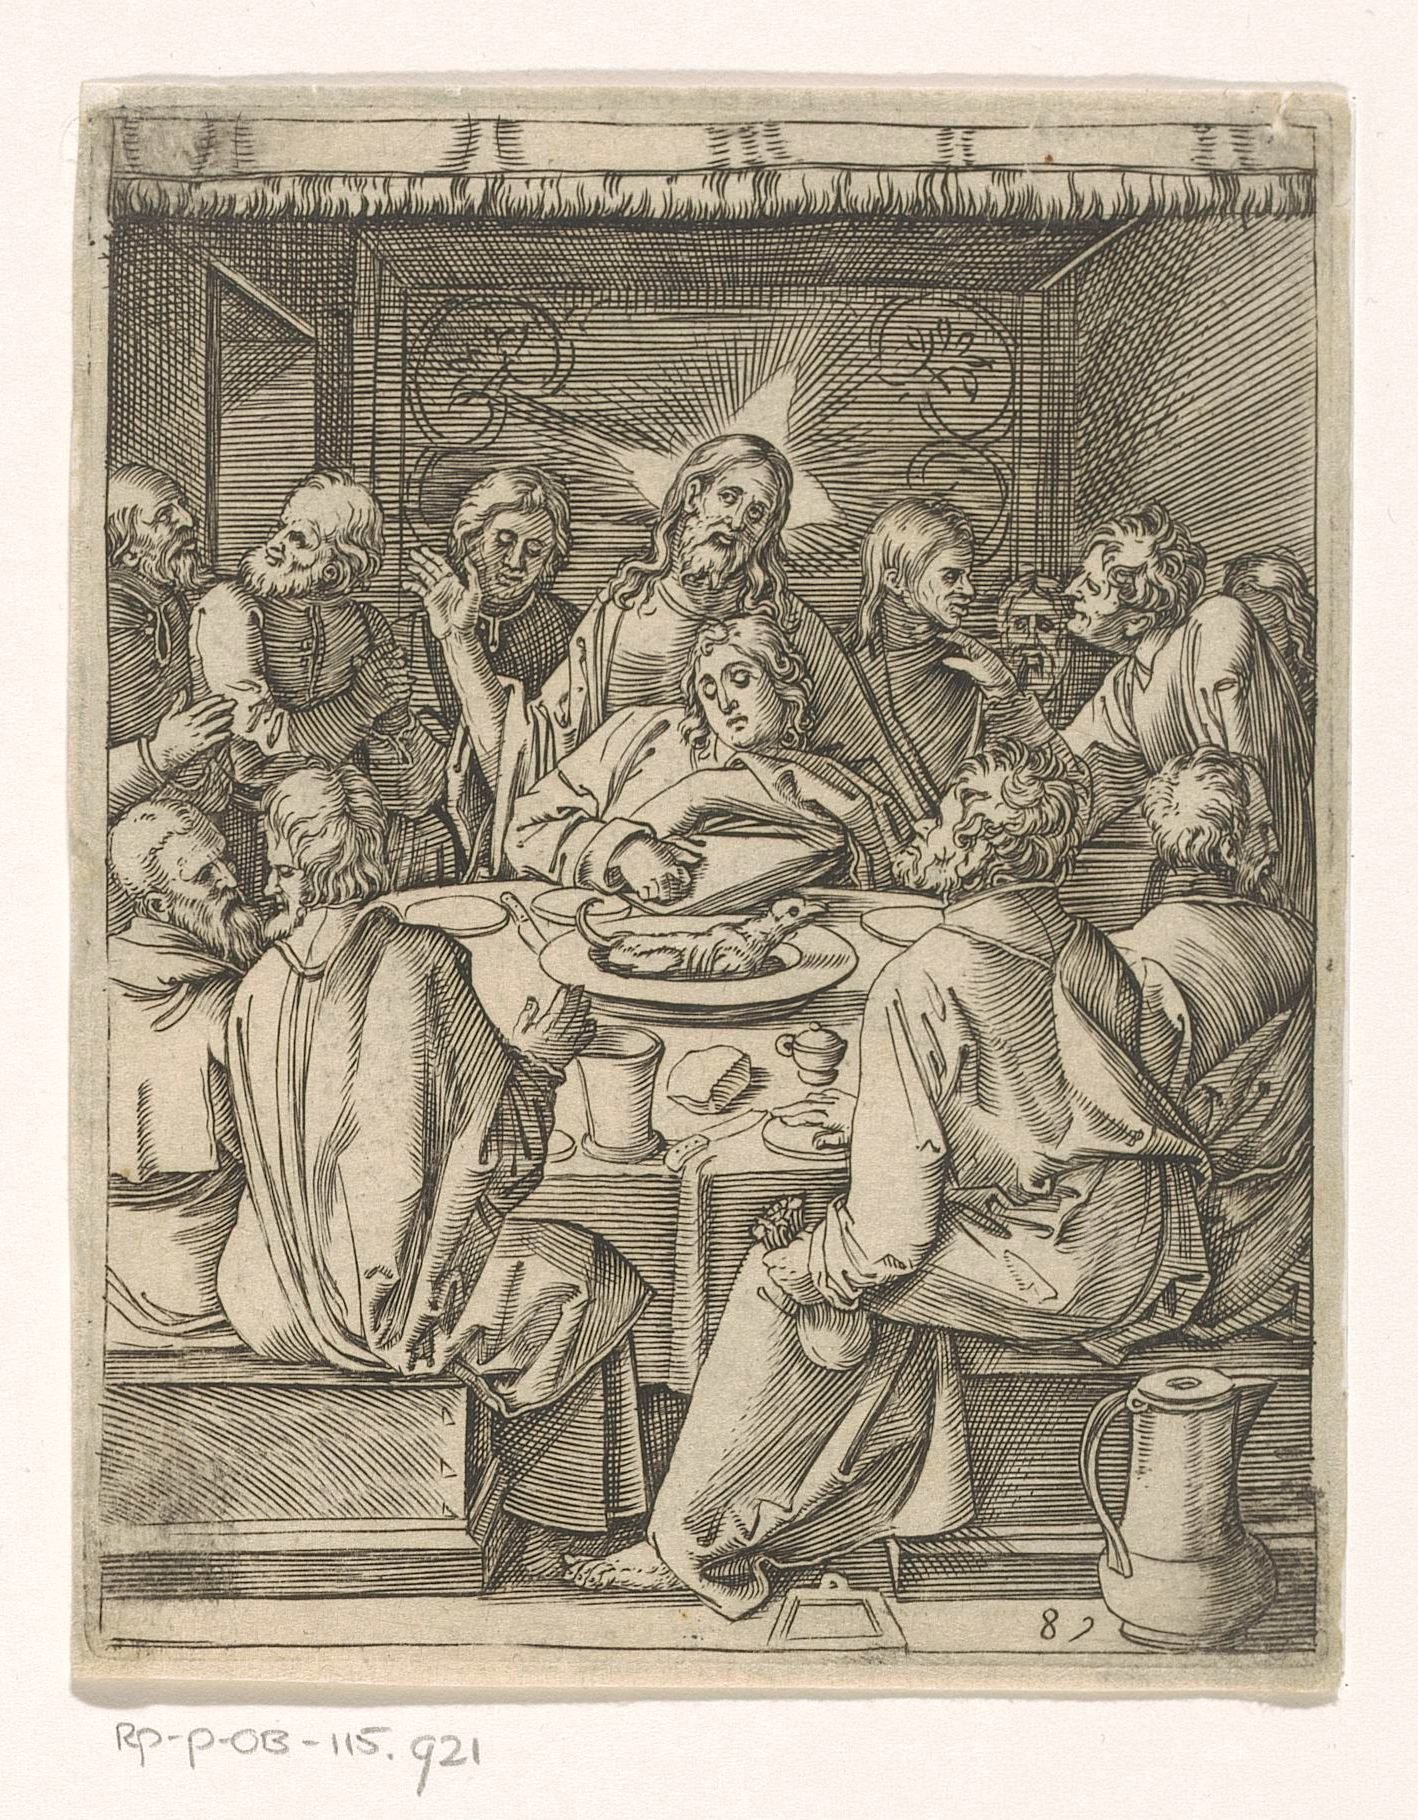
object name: print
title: Laatste Avondmaal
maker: marcantonio raimondi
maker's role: print maker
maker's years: 1470-1534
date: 1511-1534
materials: paper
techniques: engraving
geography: italy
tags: last supper (in general) (matthew 26:21-35; mark 14:18-31; luke 22:3, 22:15-23; john 13:21-38)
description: Prent naar houtsnede van Albrecht Dürer uit een serie van zevenendertig prenten met als onderwerp het levensverhaal van Christus, bekend als Passie van Christus.